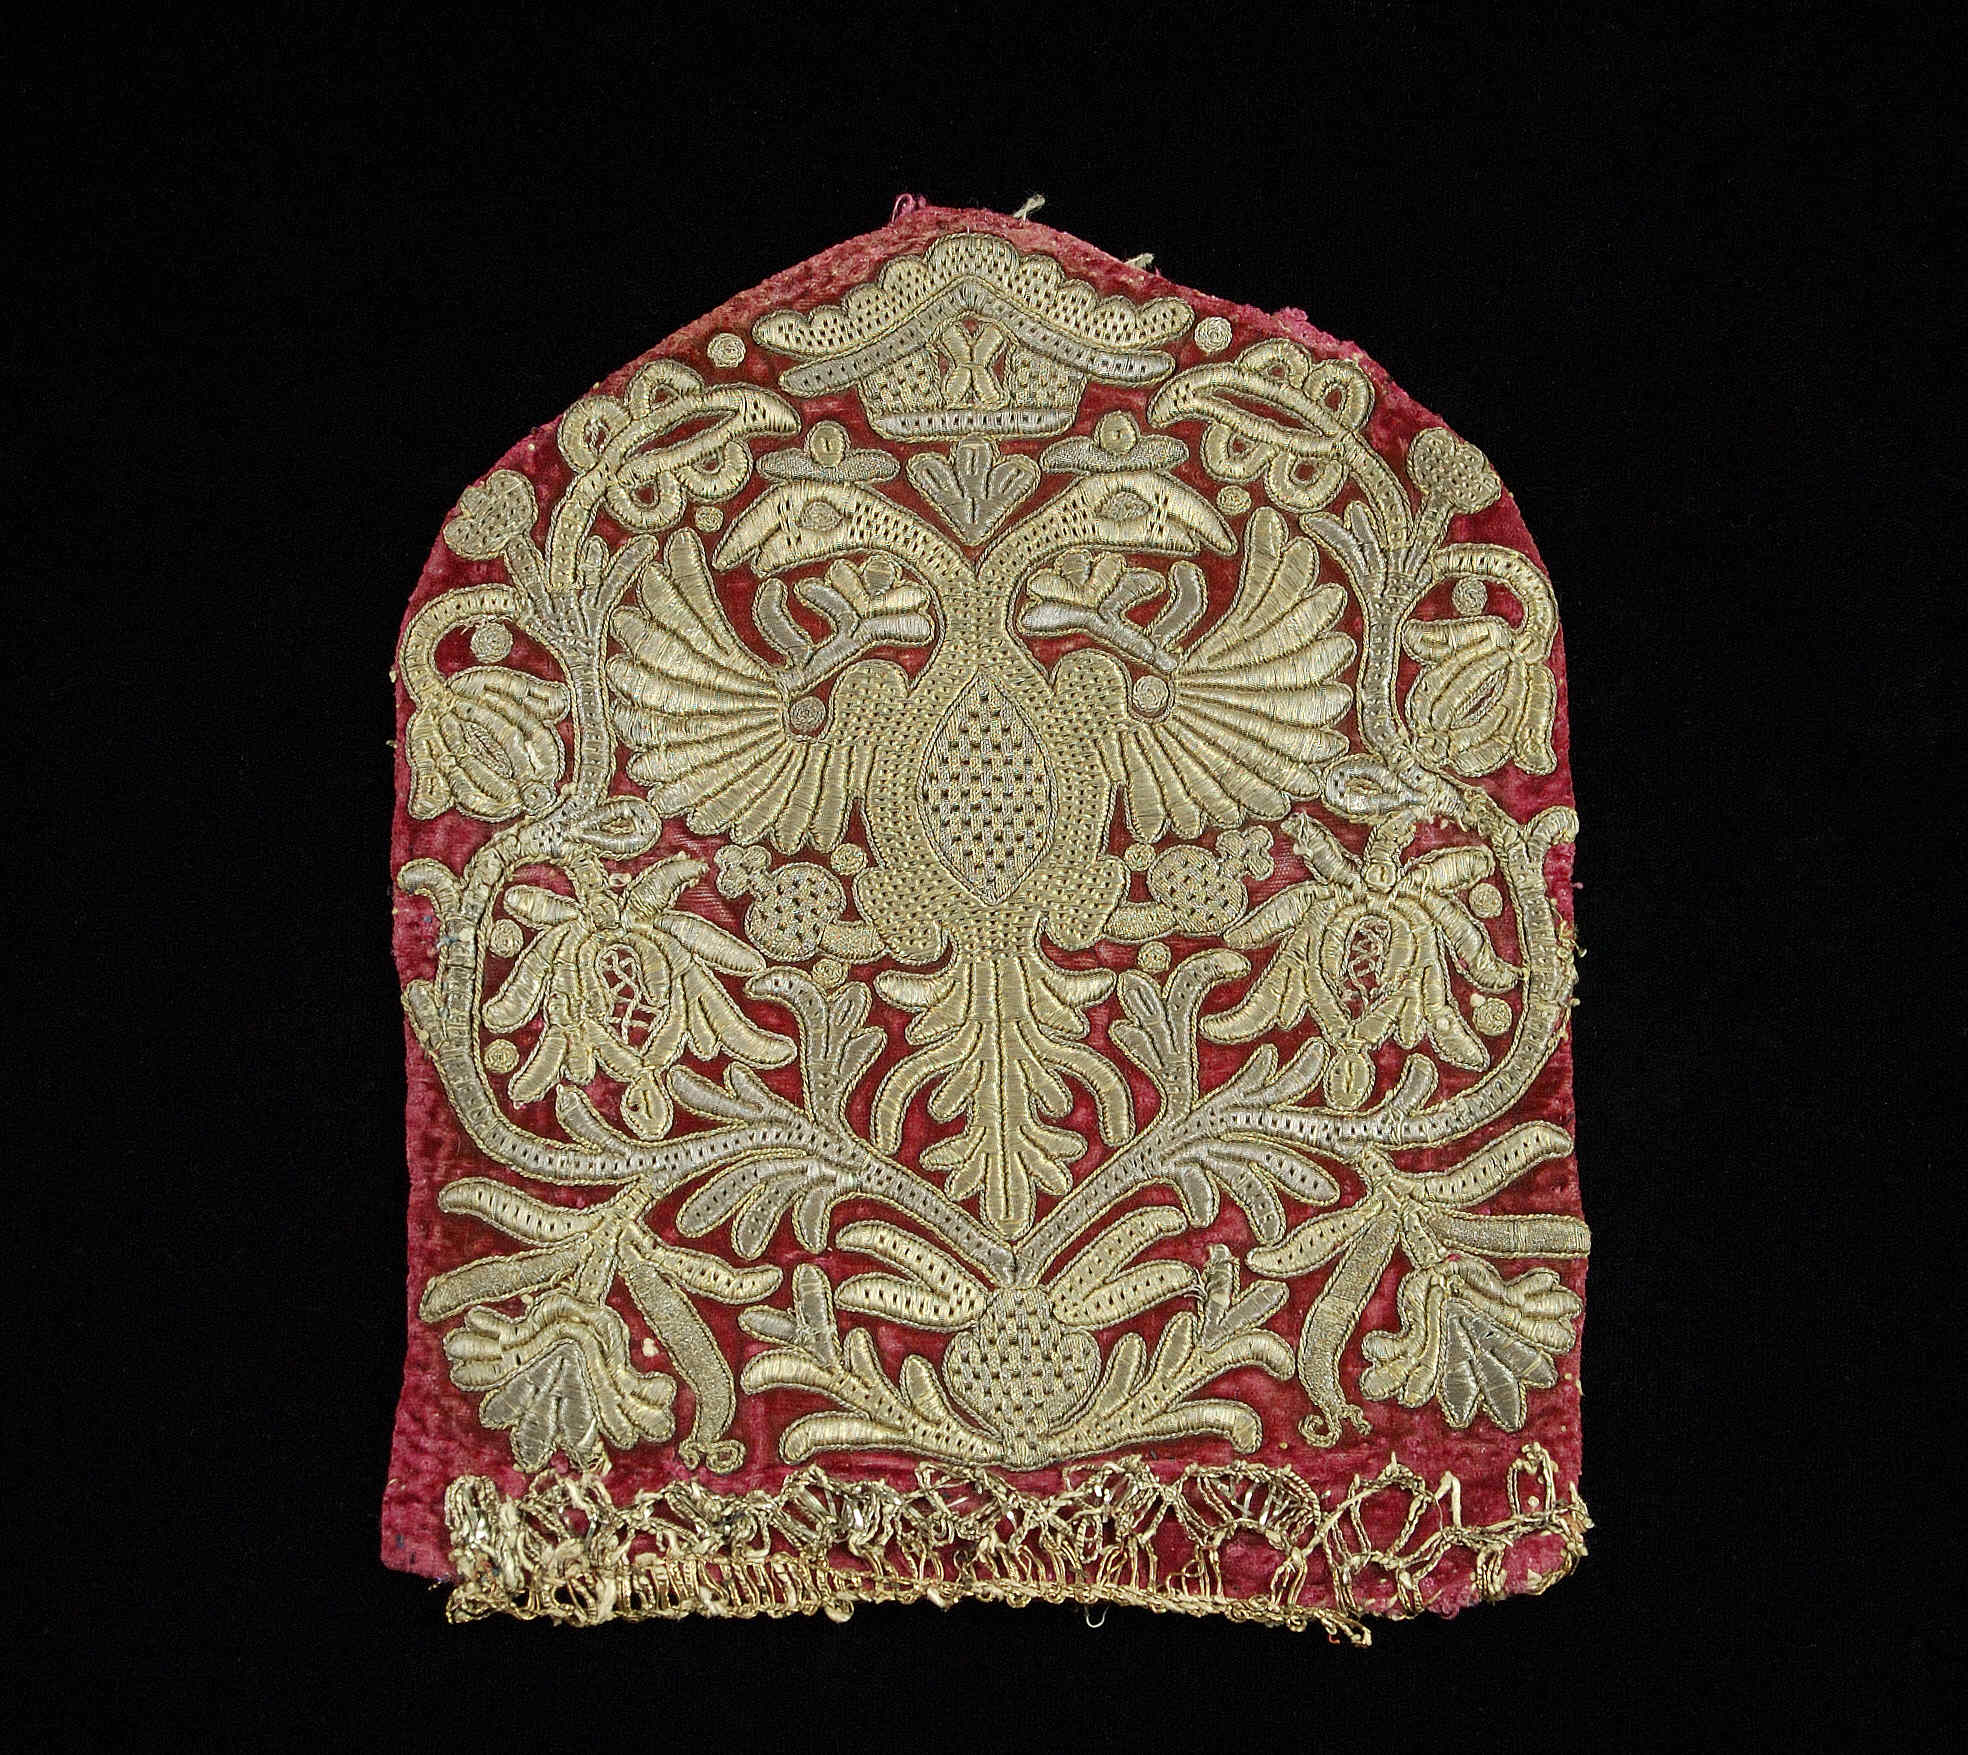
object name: headdress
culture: russian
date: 1801-1900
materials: linen, silk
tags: birds,flowers